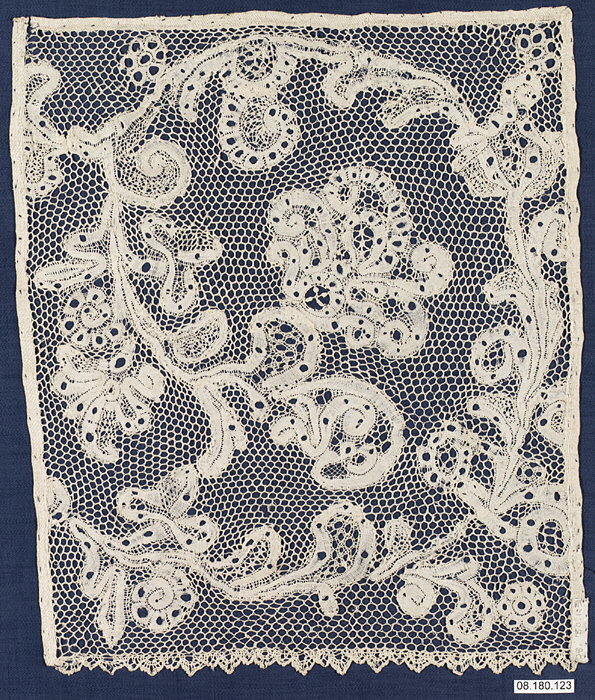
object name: piece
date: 1701-1800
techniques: lace